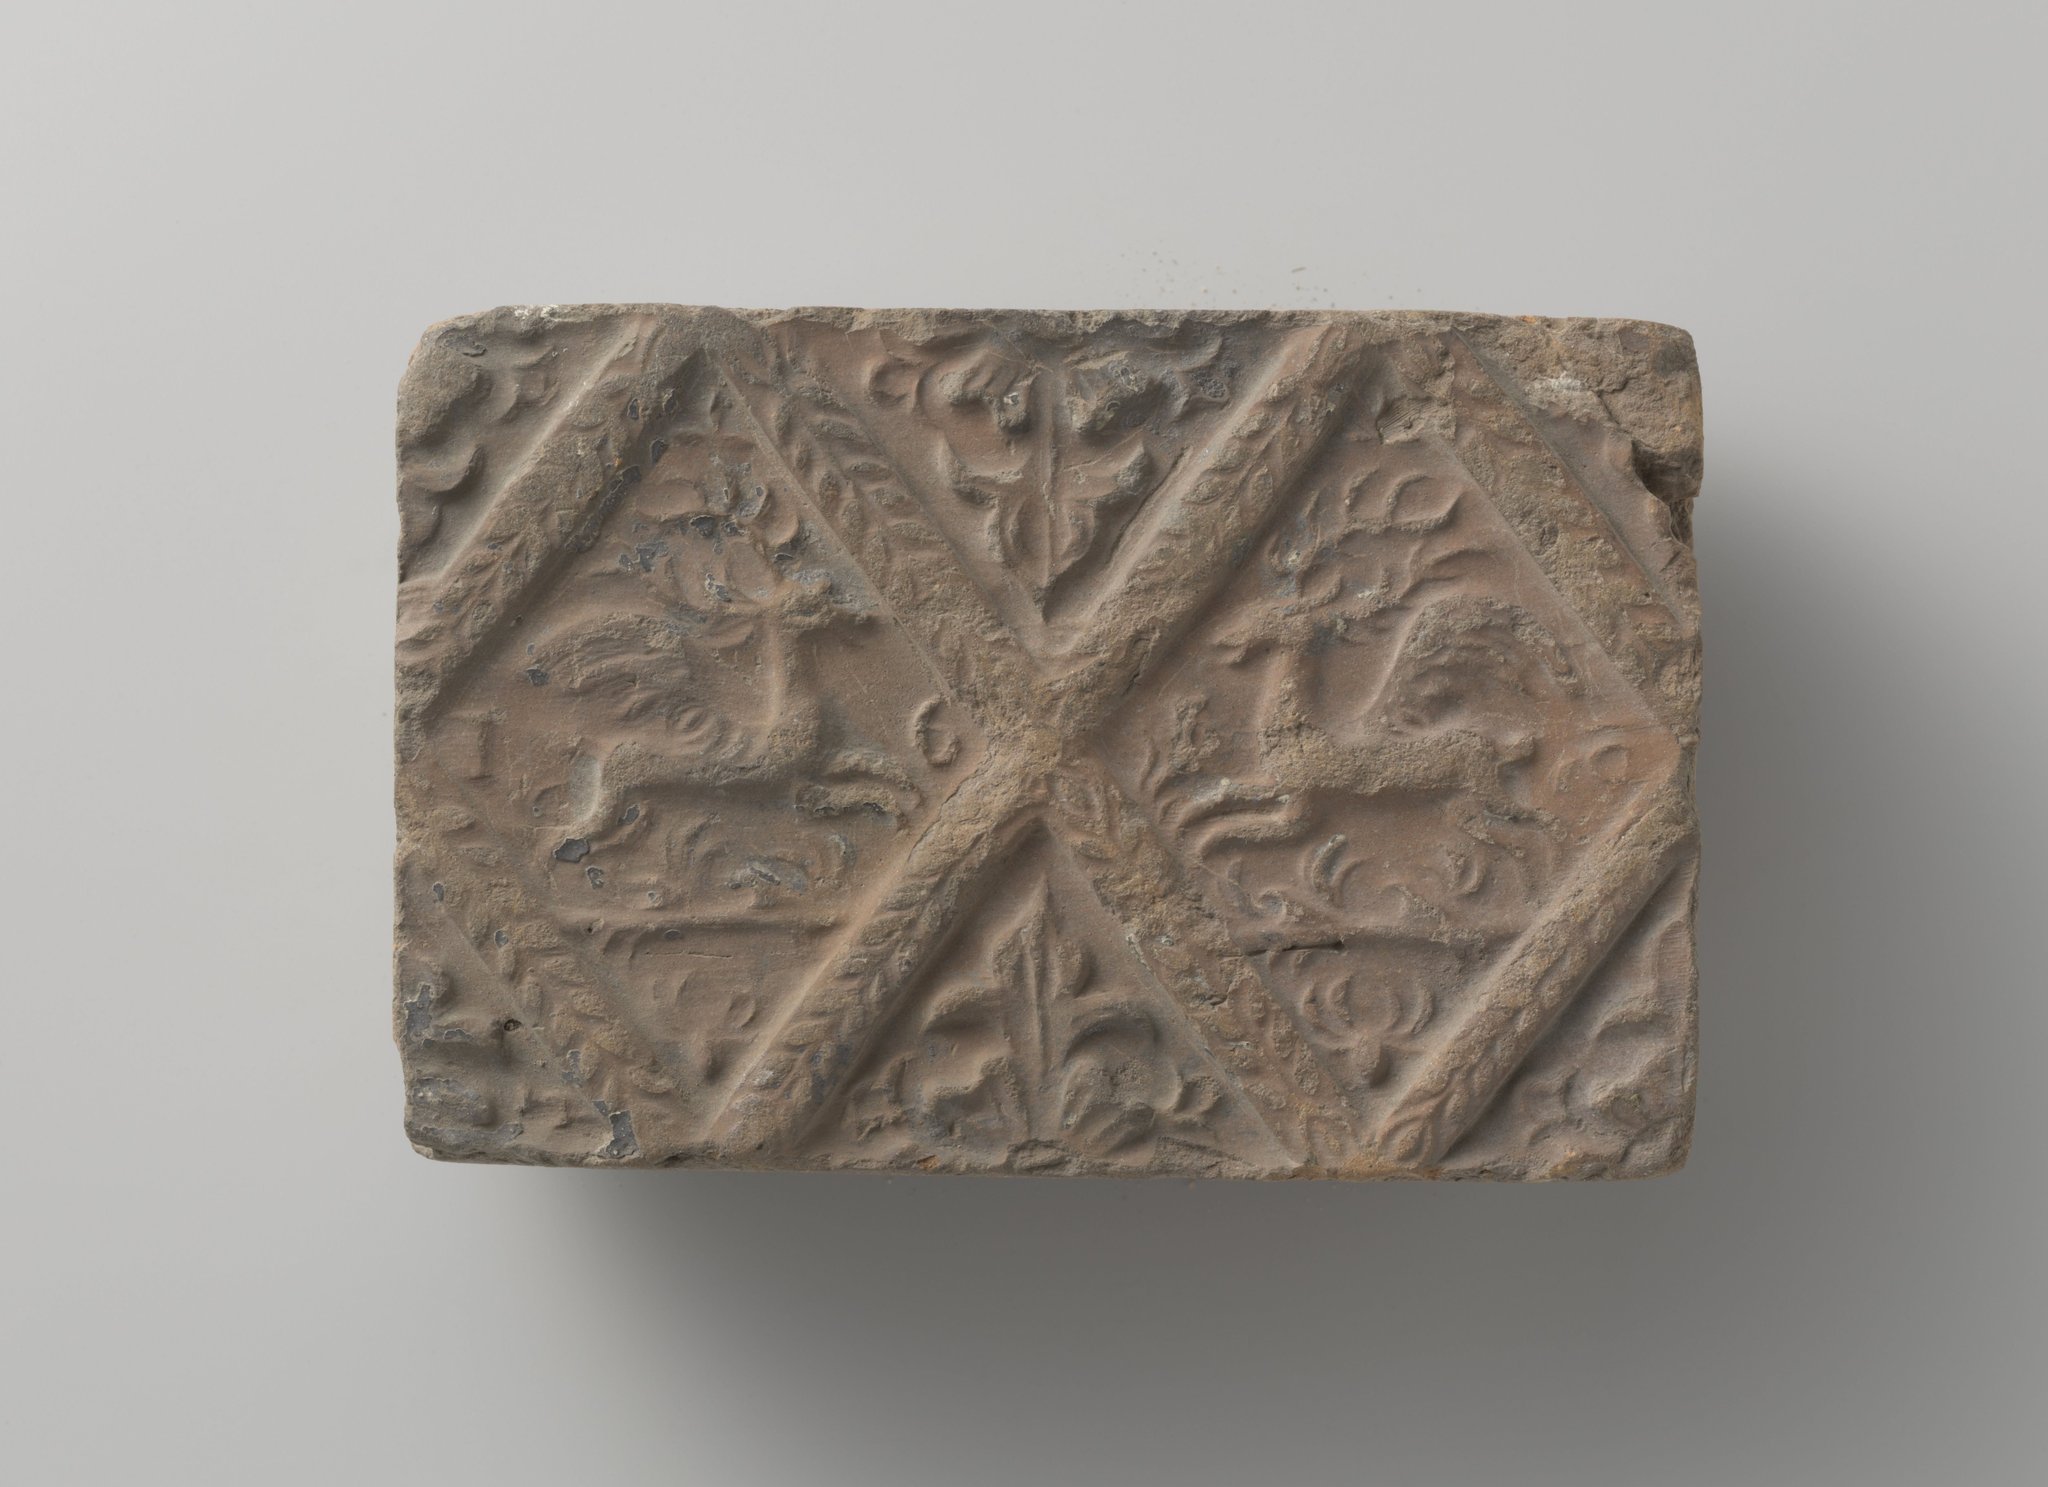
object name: architectural element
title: Haardsteen van gebakken aarde met ruitvormige verdeling, met in twee ruiten twee gevleugelde herten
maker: Anonymous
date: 1605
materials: earthenware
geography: southern netherlands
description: Twee haardstenen van gebakken aarde met ruitvormige verdeling, met in twee ruiten twee gevleugelde herten. De één met het jaartal 1605. De ander met het jaartal 161..